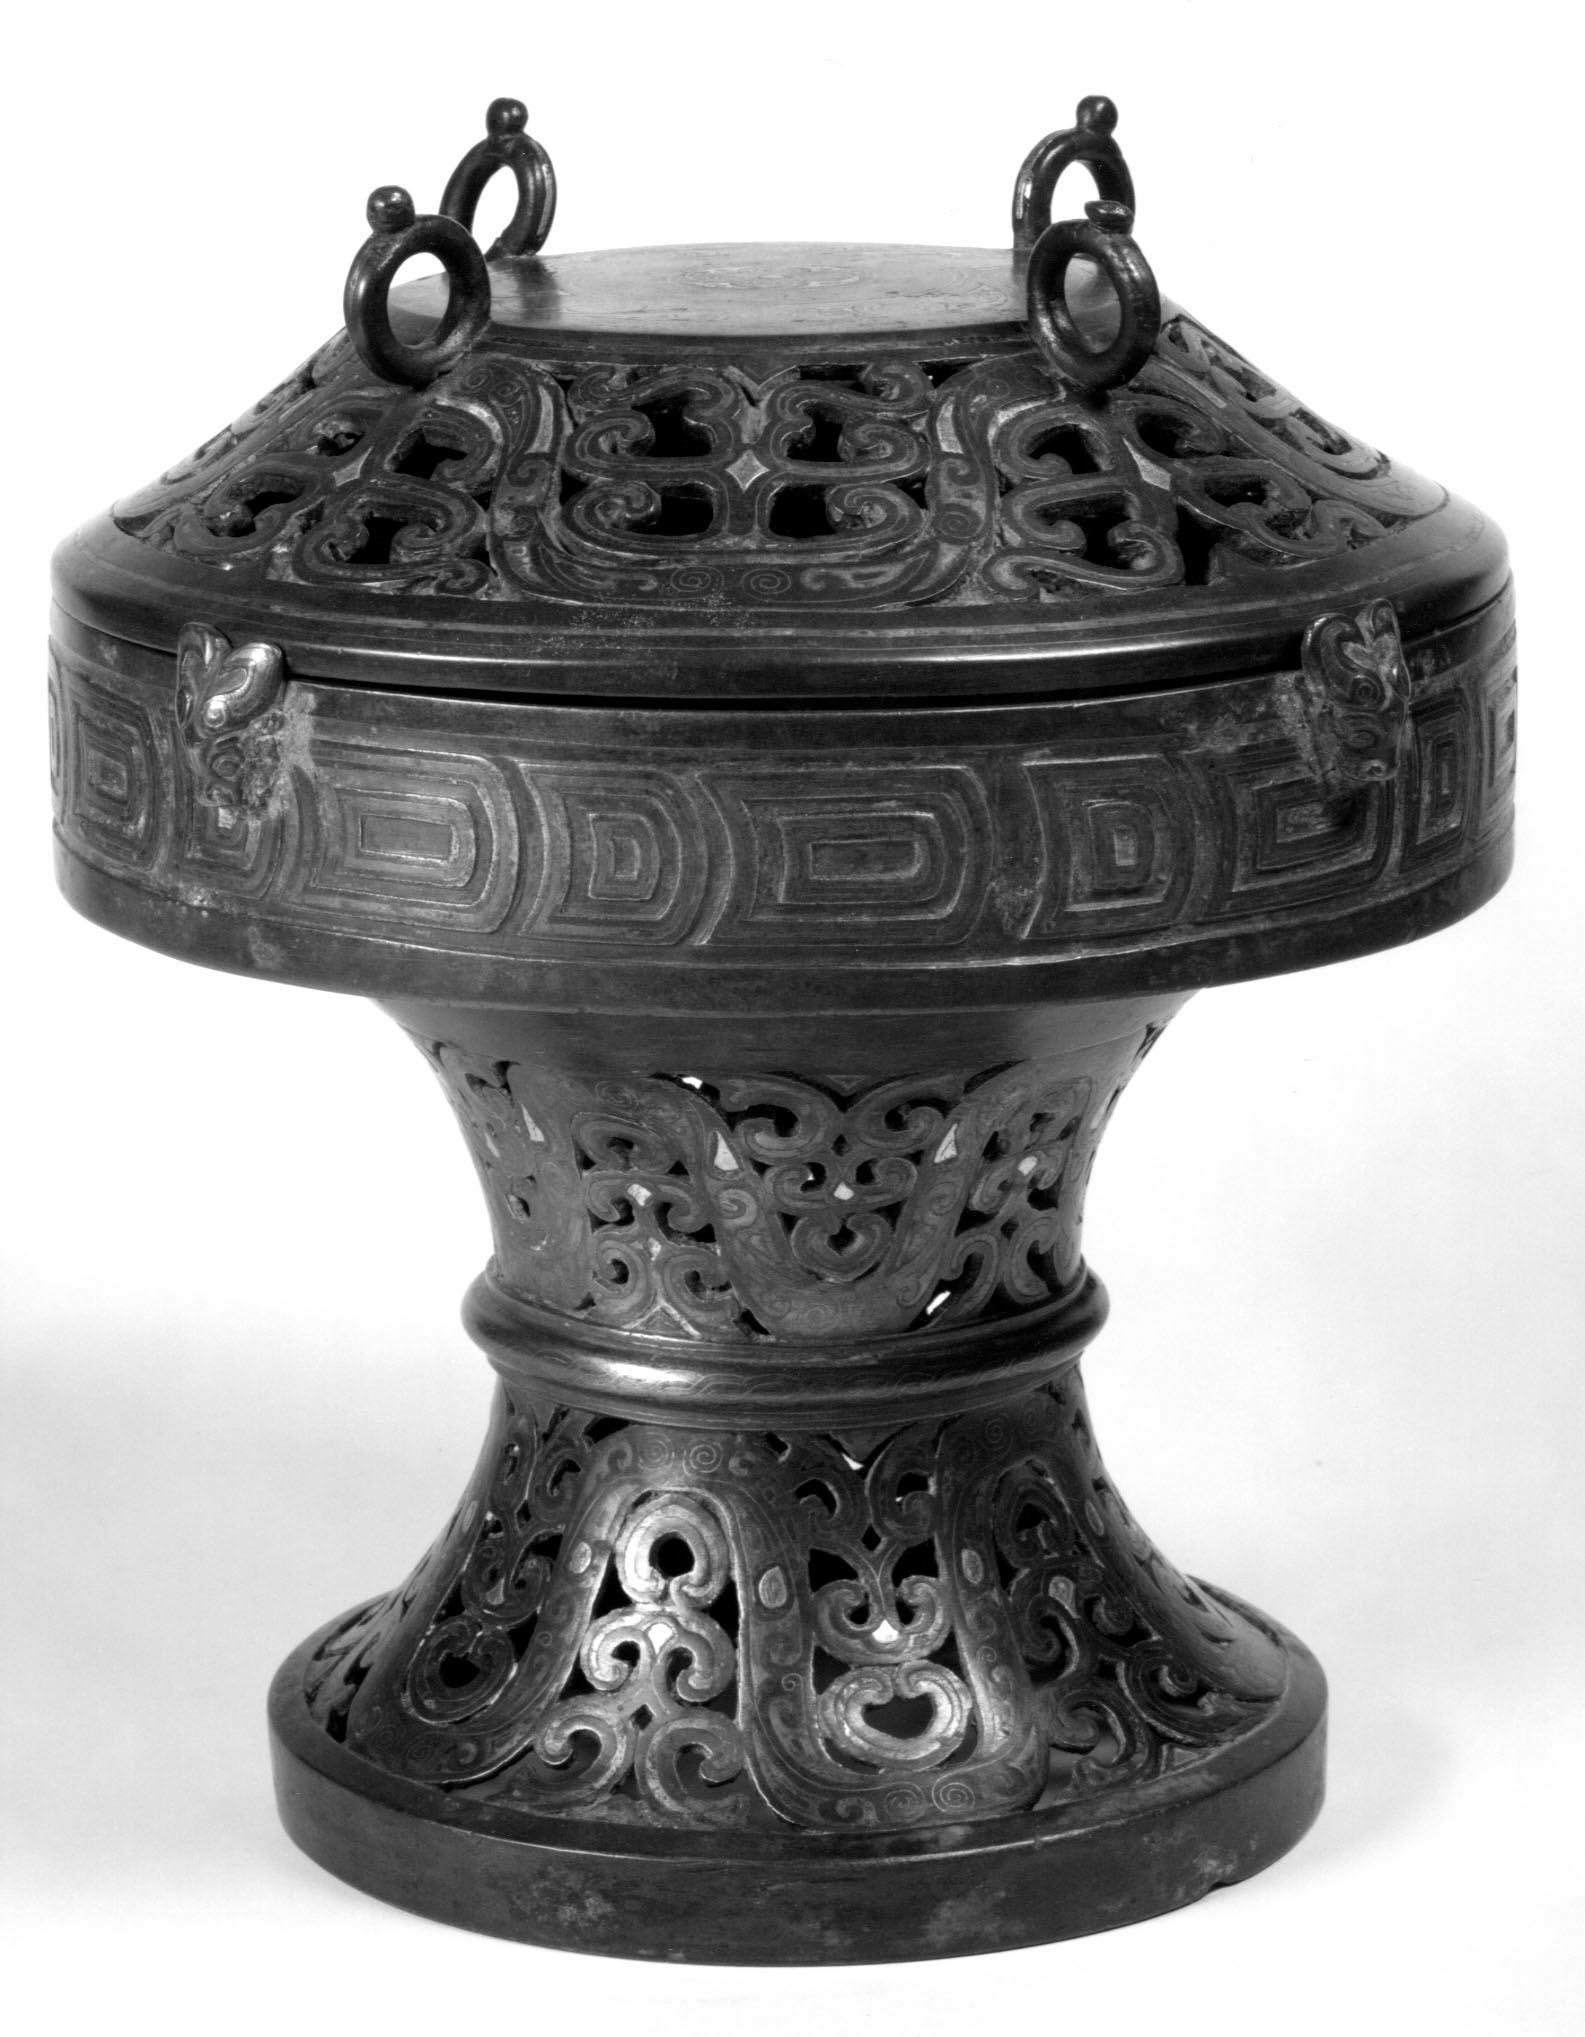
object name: vessel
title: Ritual Offering Vessel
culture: chinese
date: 1101-1700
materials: bronze, copper, gold, silver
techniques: inlay